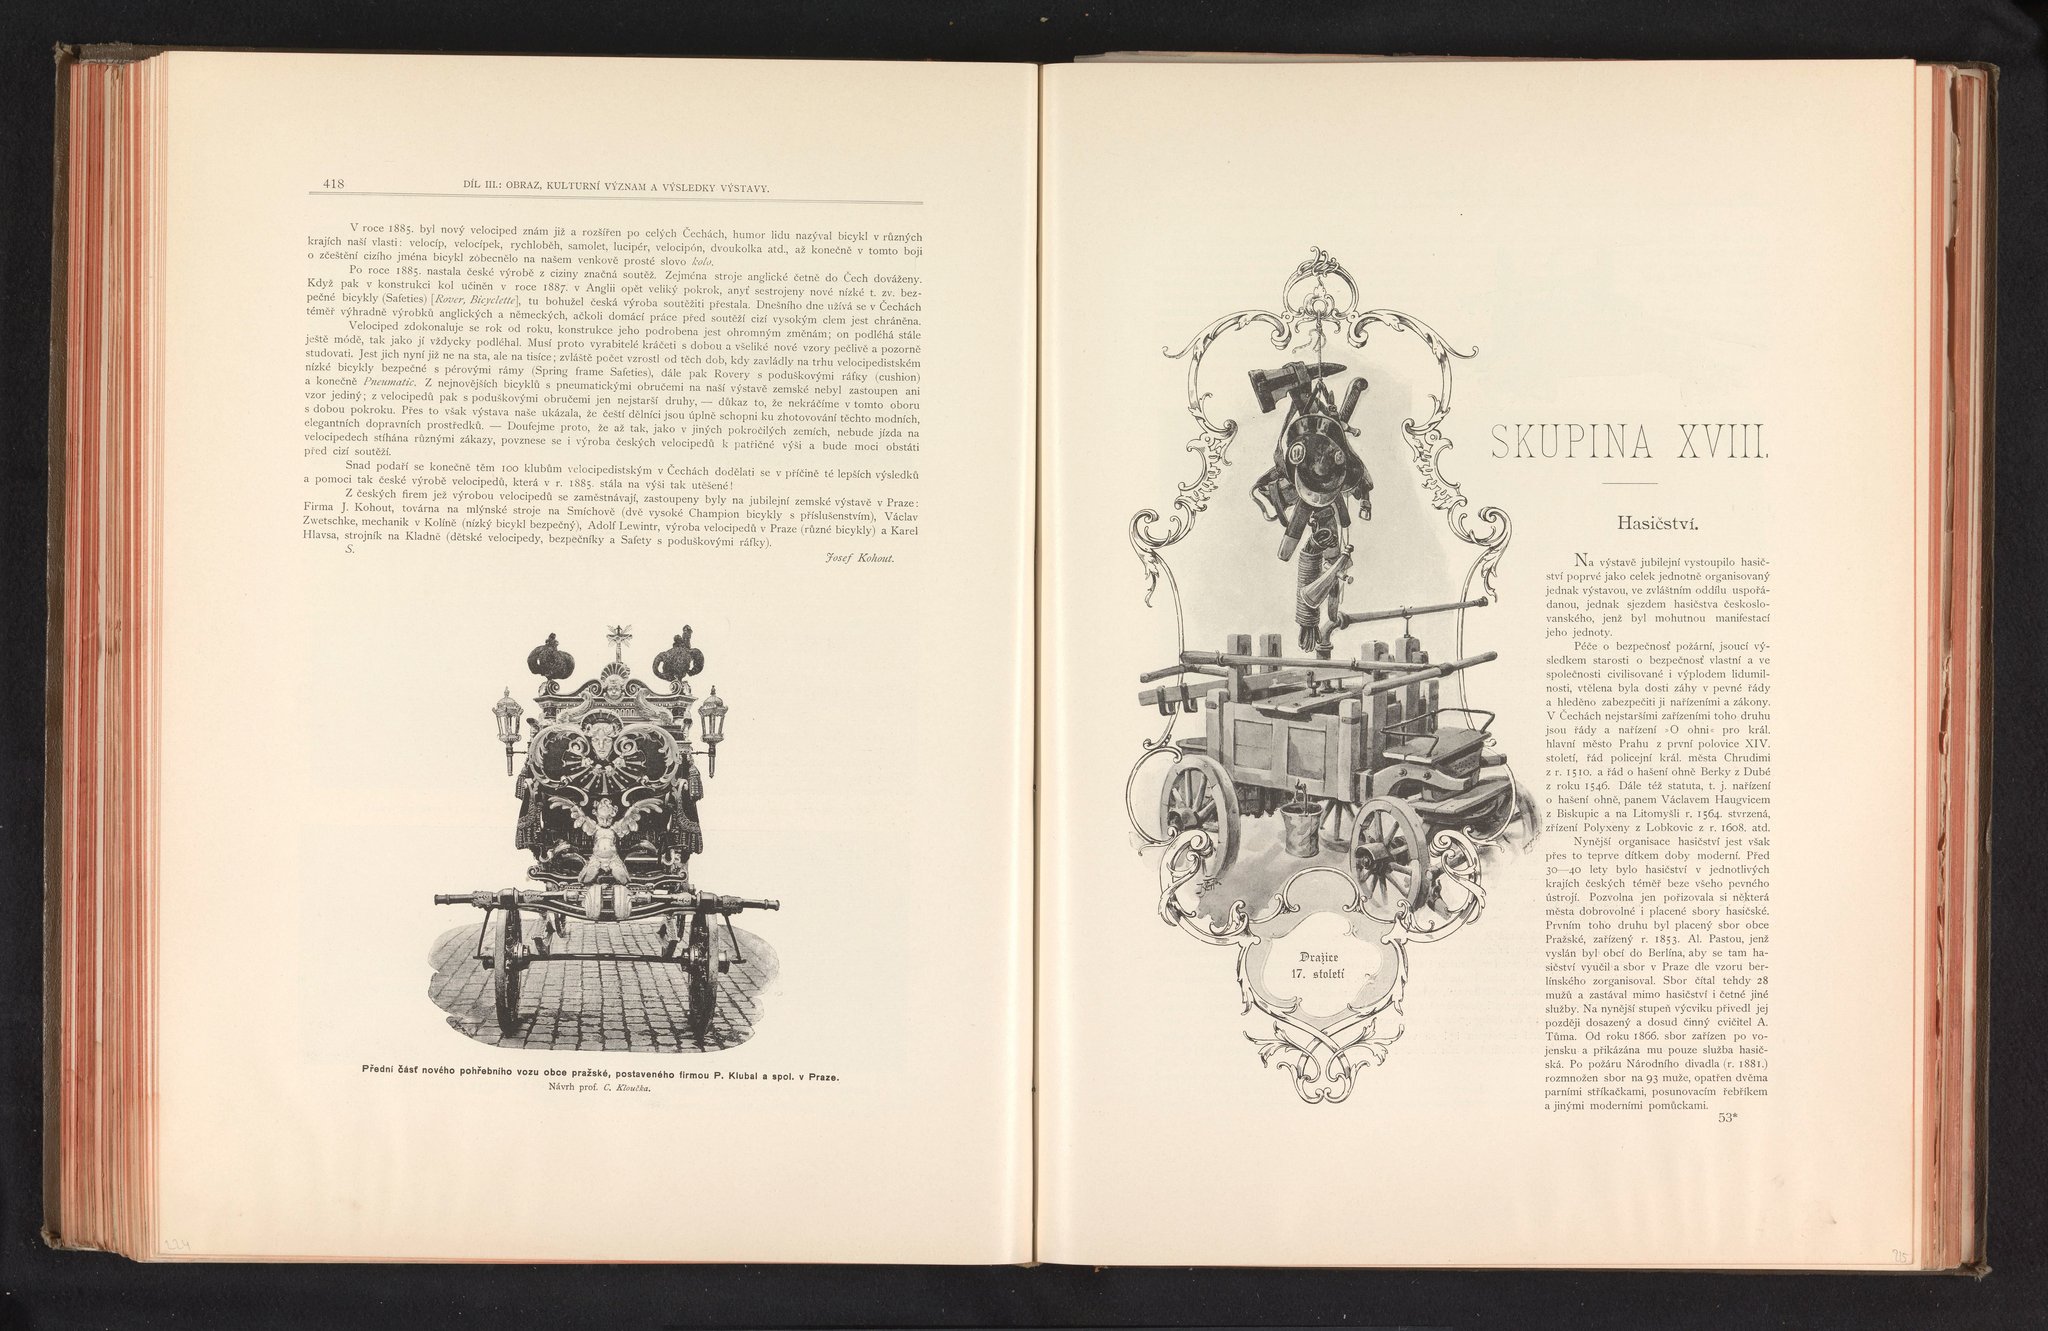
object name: photomechanical print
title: Predni cast nového pohrebniho vozu obce prazské, postaveného firmou P. Klubal a spol. v Praze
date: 1890-1895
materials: paper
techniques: autotype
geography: prague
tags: funeral carriages